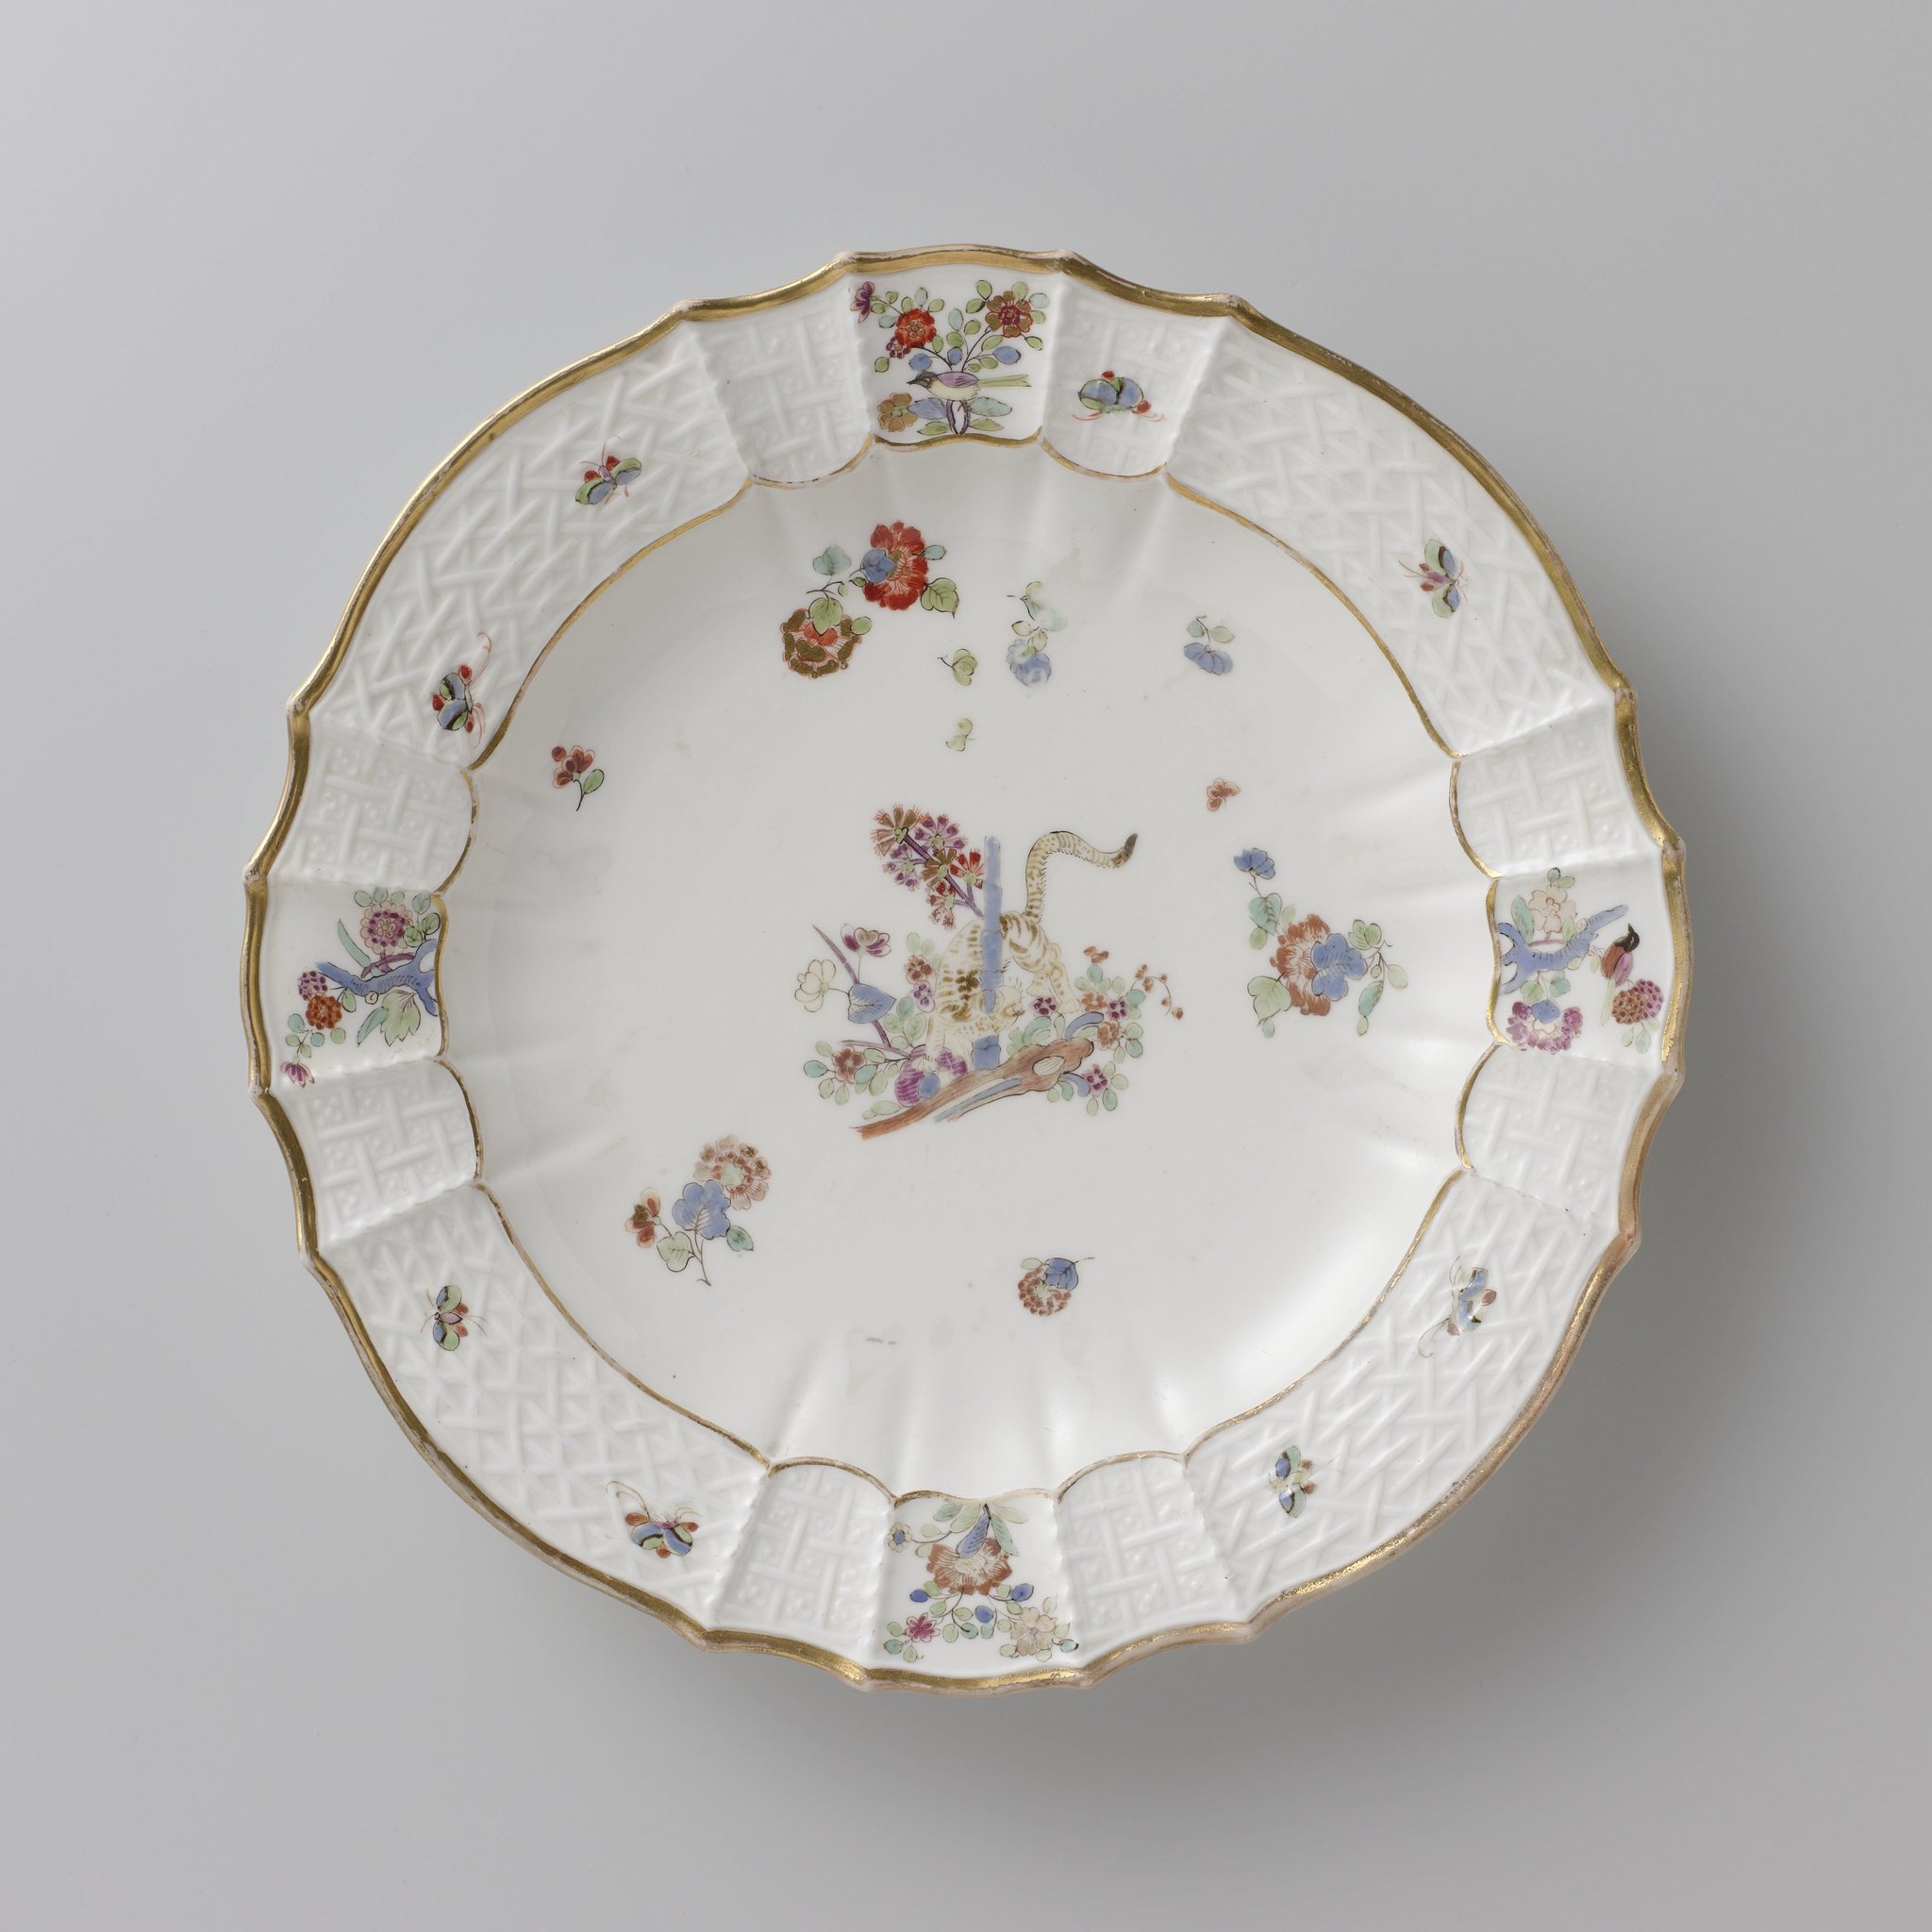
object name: eating drinking utensil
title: Rond bord, veelkleurig beschilderd met een Kakiemon-decor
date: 1740-1745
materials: porcelain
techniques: painted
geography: meissen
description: Rond bord van beschilderd porselein. Het bord is geribd en heeft een geschulpte rand. Het bord is beschilderd met een tijger die om een blauwe bamboestengel tussen bloemen is gedraaid, gestrooide Indianische Blumen, vlinders en takken waarop vogels. De rand is versierd met het 'Altbrandenstein'-patroon. Het bord is gemerkt.